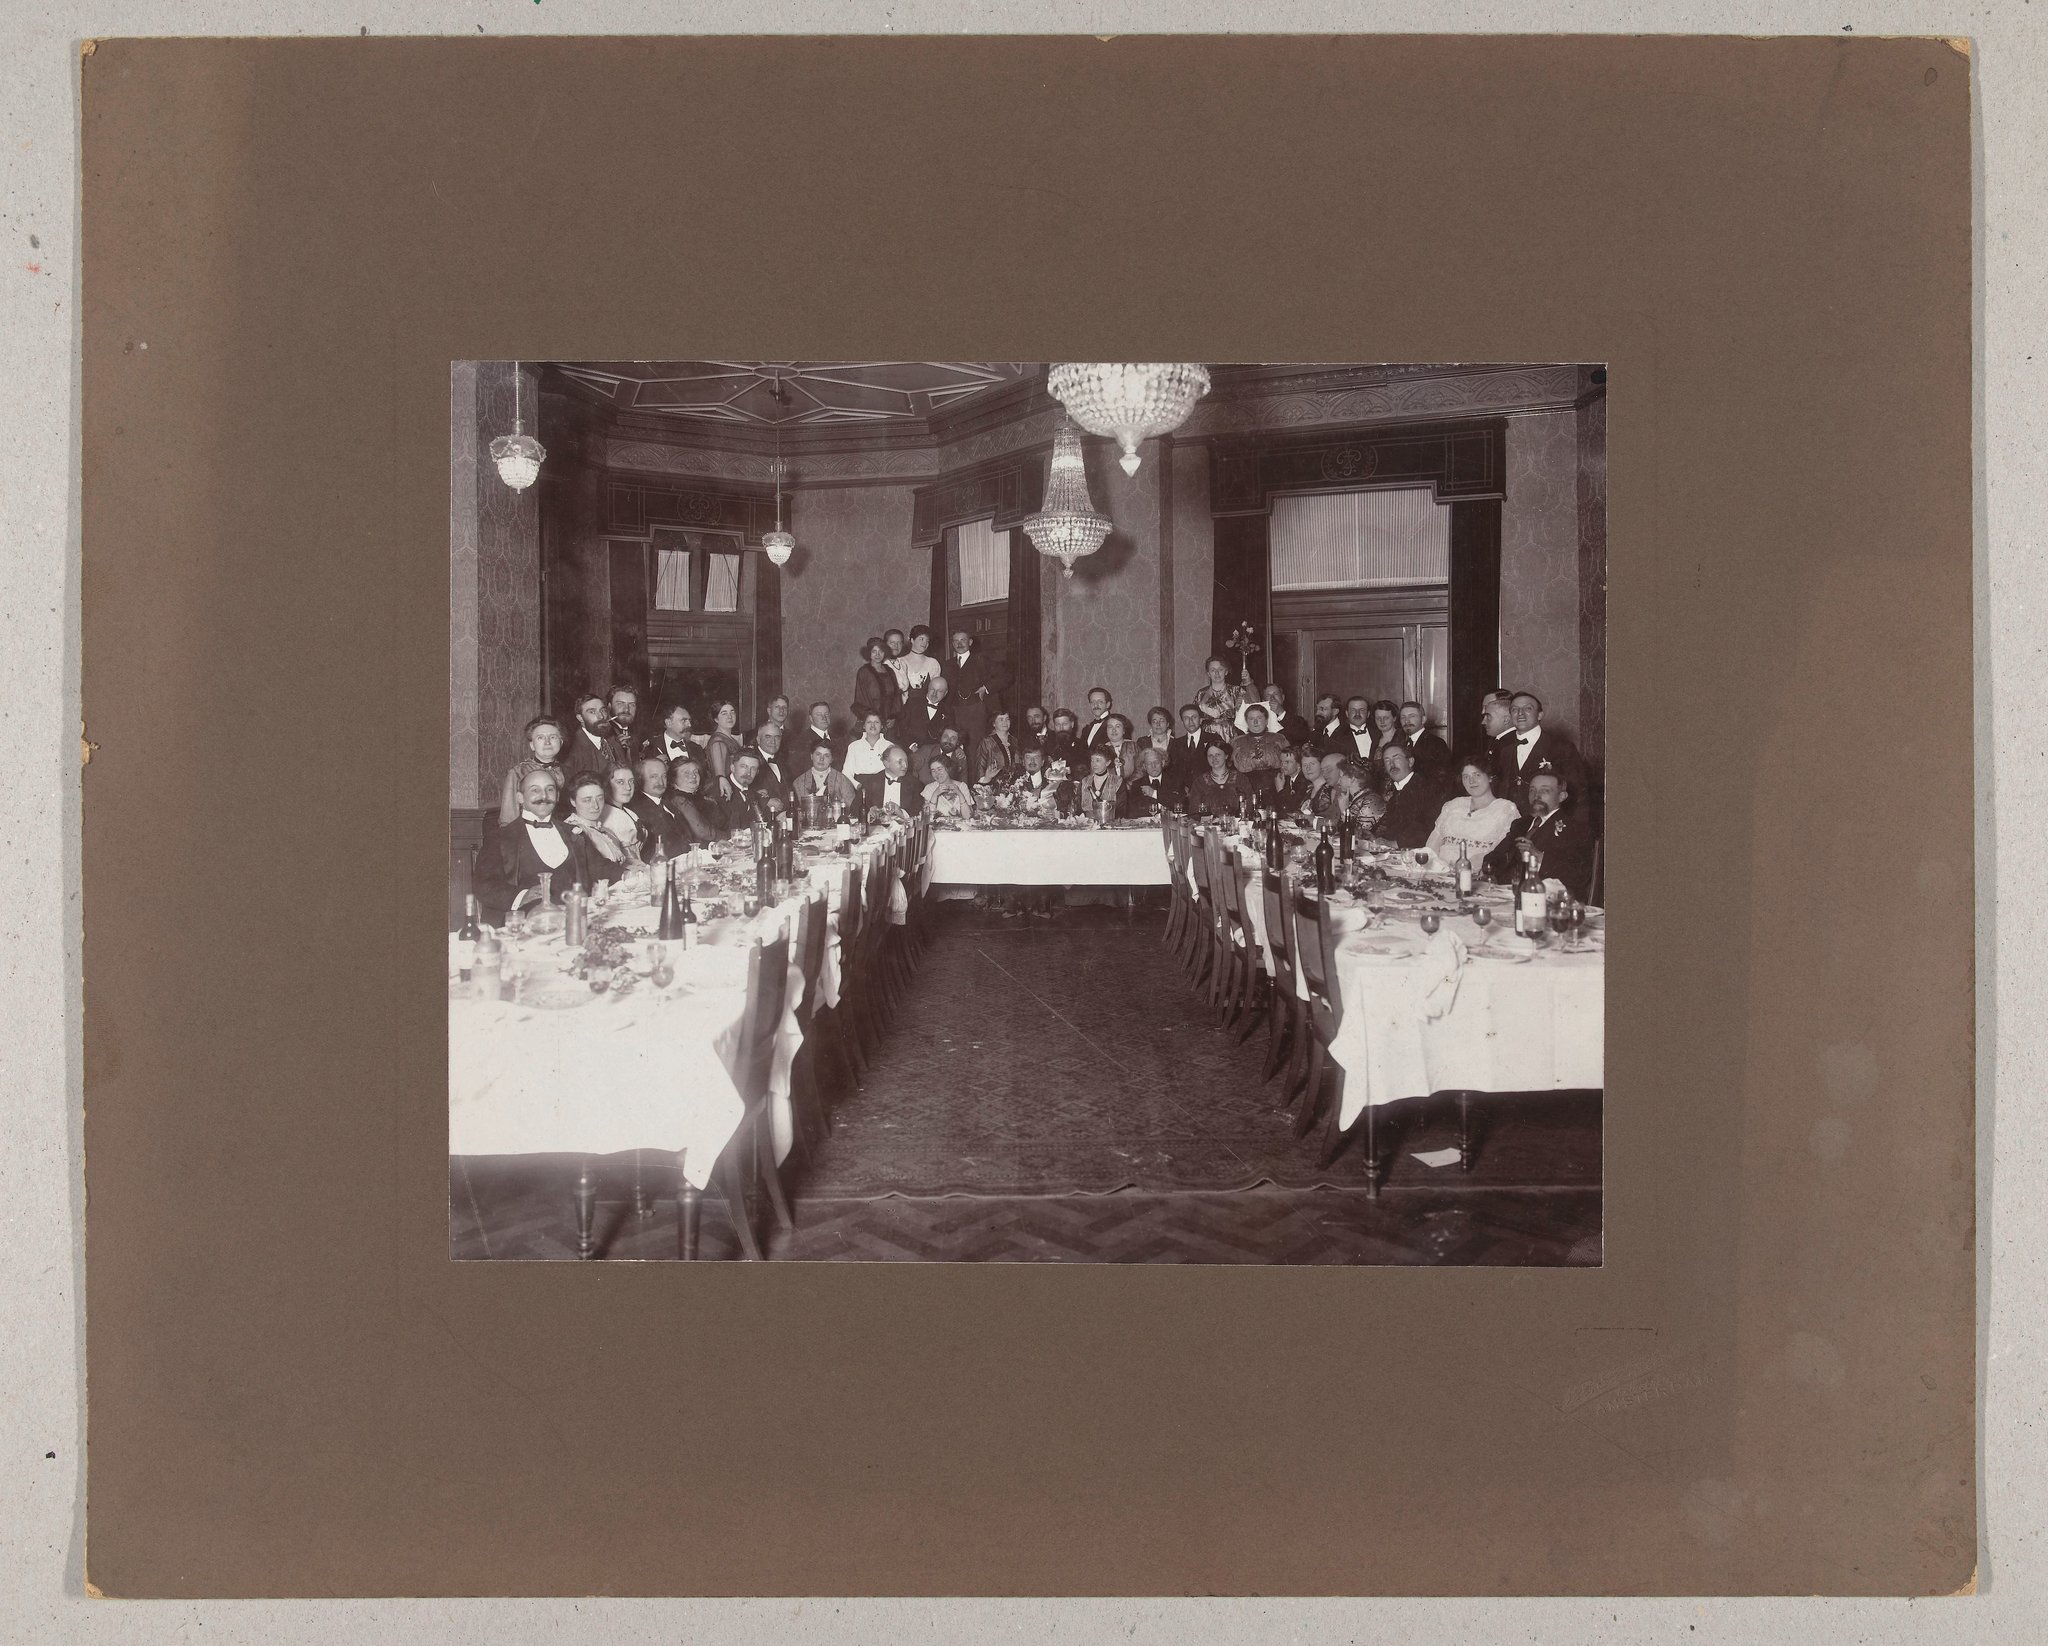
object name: photograph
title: Groepsportret tijdens een diner met o.a. Simon Maris en Gerrit Heinrich Kroon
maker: nicolaas schuitvlot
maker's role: fotograaf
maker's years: 1859-1947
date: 1910-1920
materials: paper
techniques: collodion silver print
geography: amsterdam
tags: the hague, amsterdam, painter, simon maris, anonymous historical persons portrayed in a group, in a group-portrait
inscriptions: name: ‘Nico Schuitvlot Amsterdam’